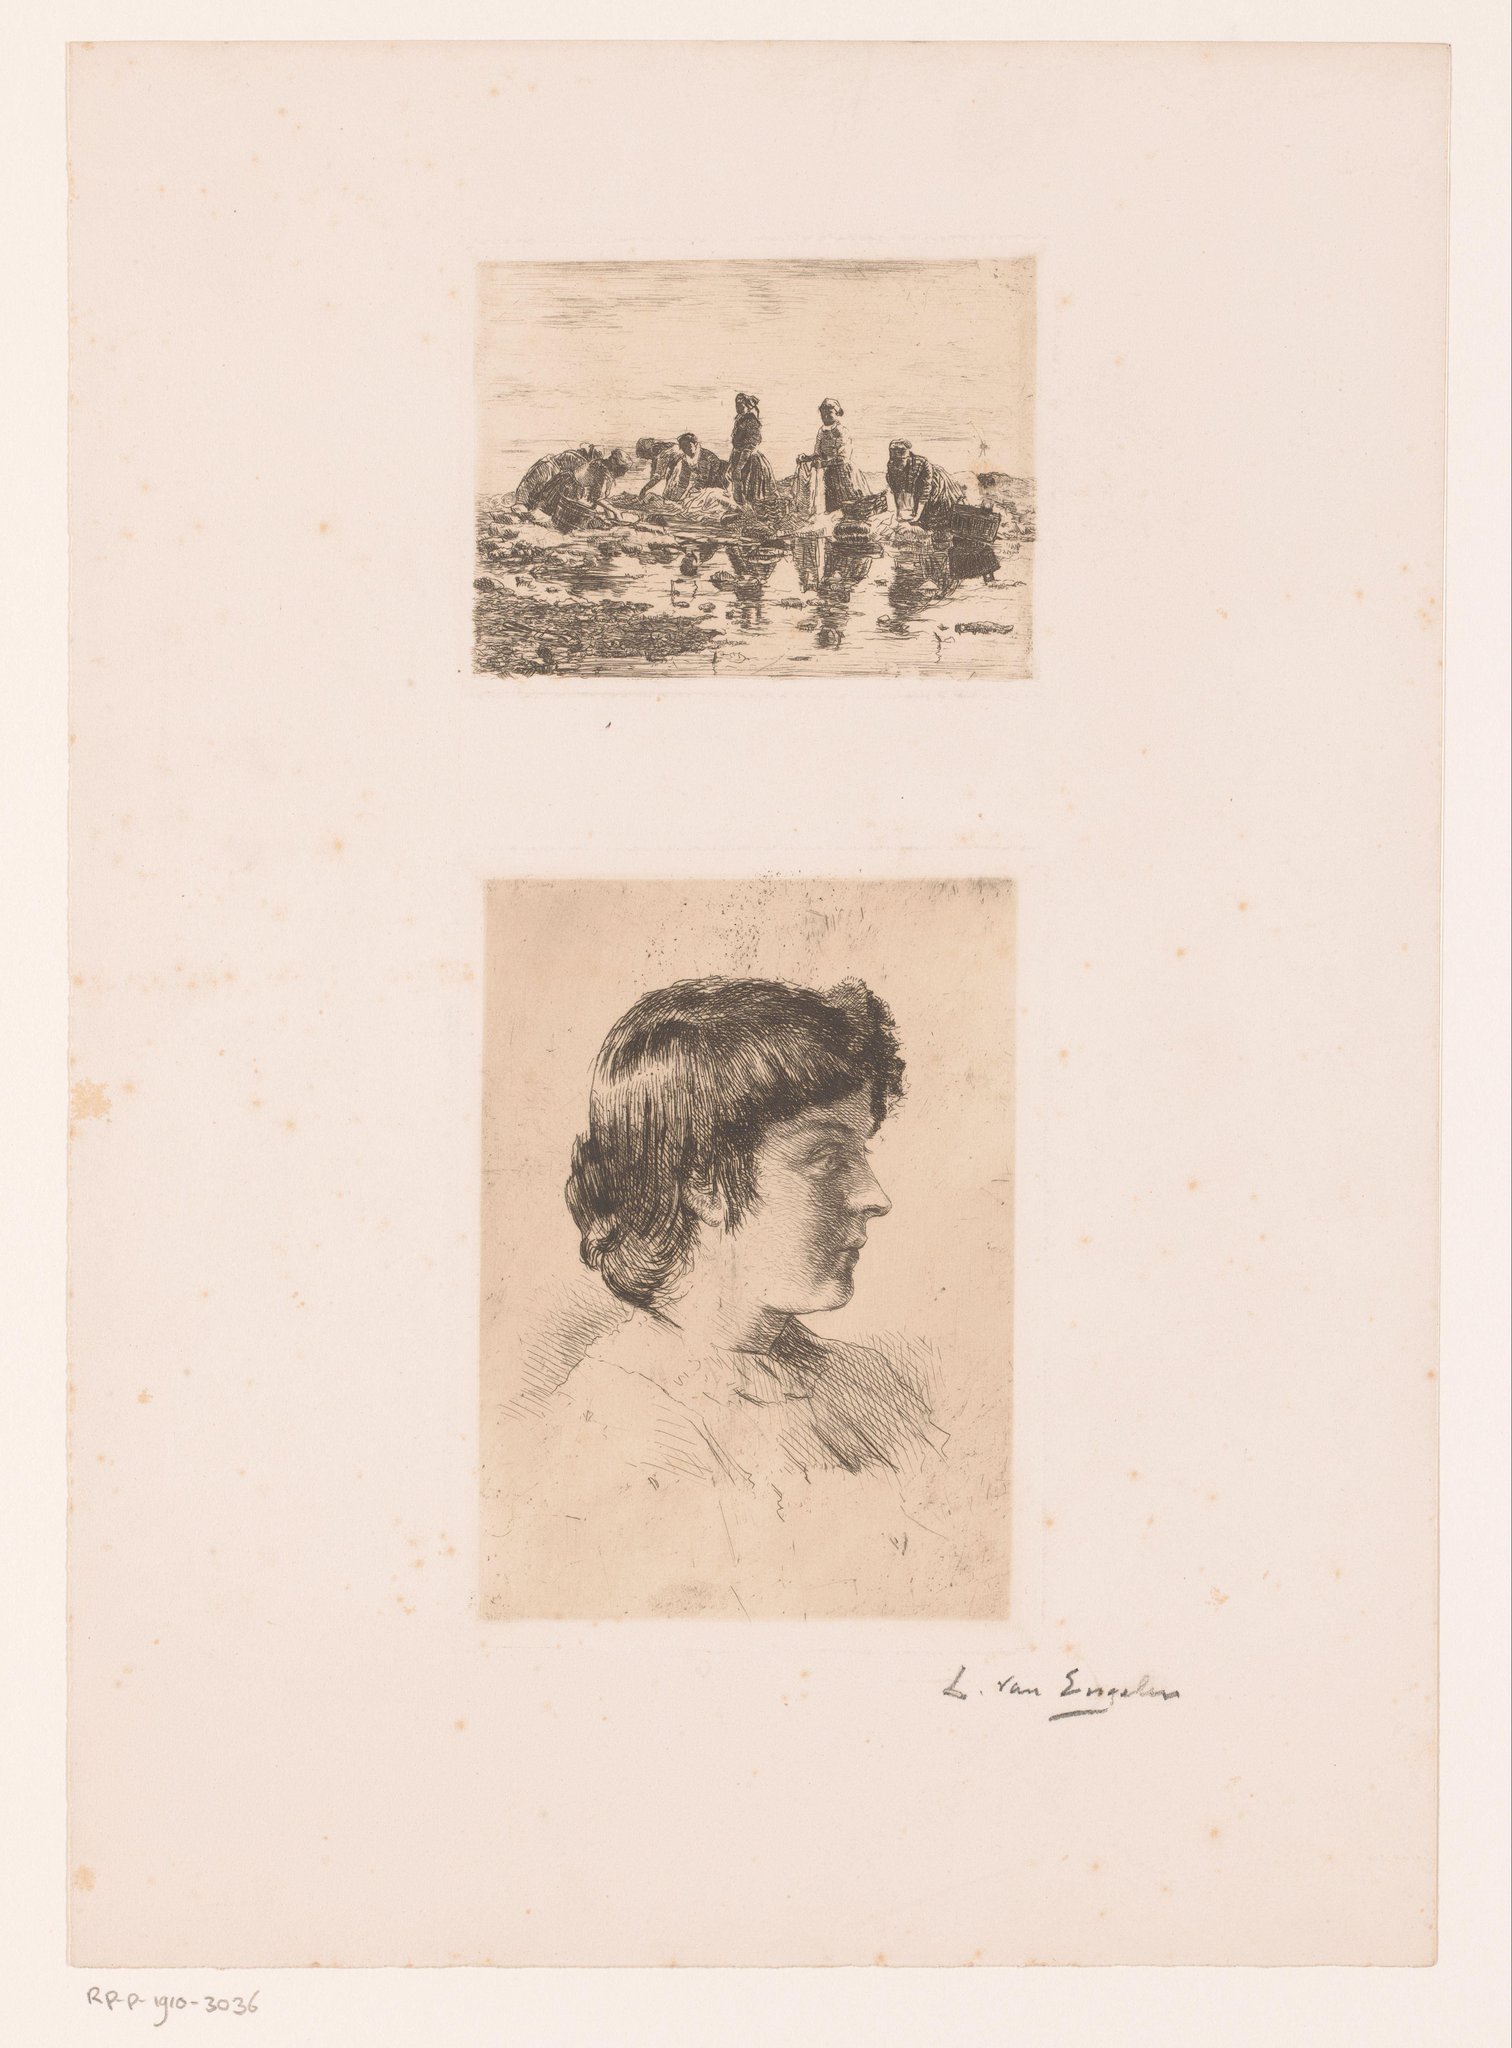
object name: print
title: Buste van een onbekende jonge vrouw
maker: louis van engelen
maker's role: print maker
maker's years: 1856-1940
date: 1866-1910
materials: paper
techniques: etching, intaglio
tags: river bank, laundering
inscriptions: collector's mark: Lugt 2228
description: Prent met twee afdrukken. Boven vrouwen die kleding wassen aan een oever. Onder een portretbuste van een onbekende jonge vrouw.